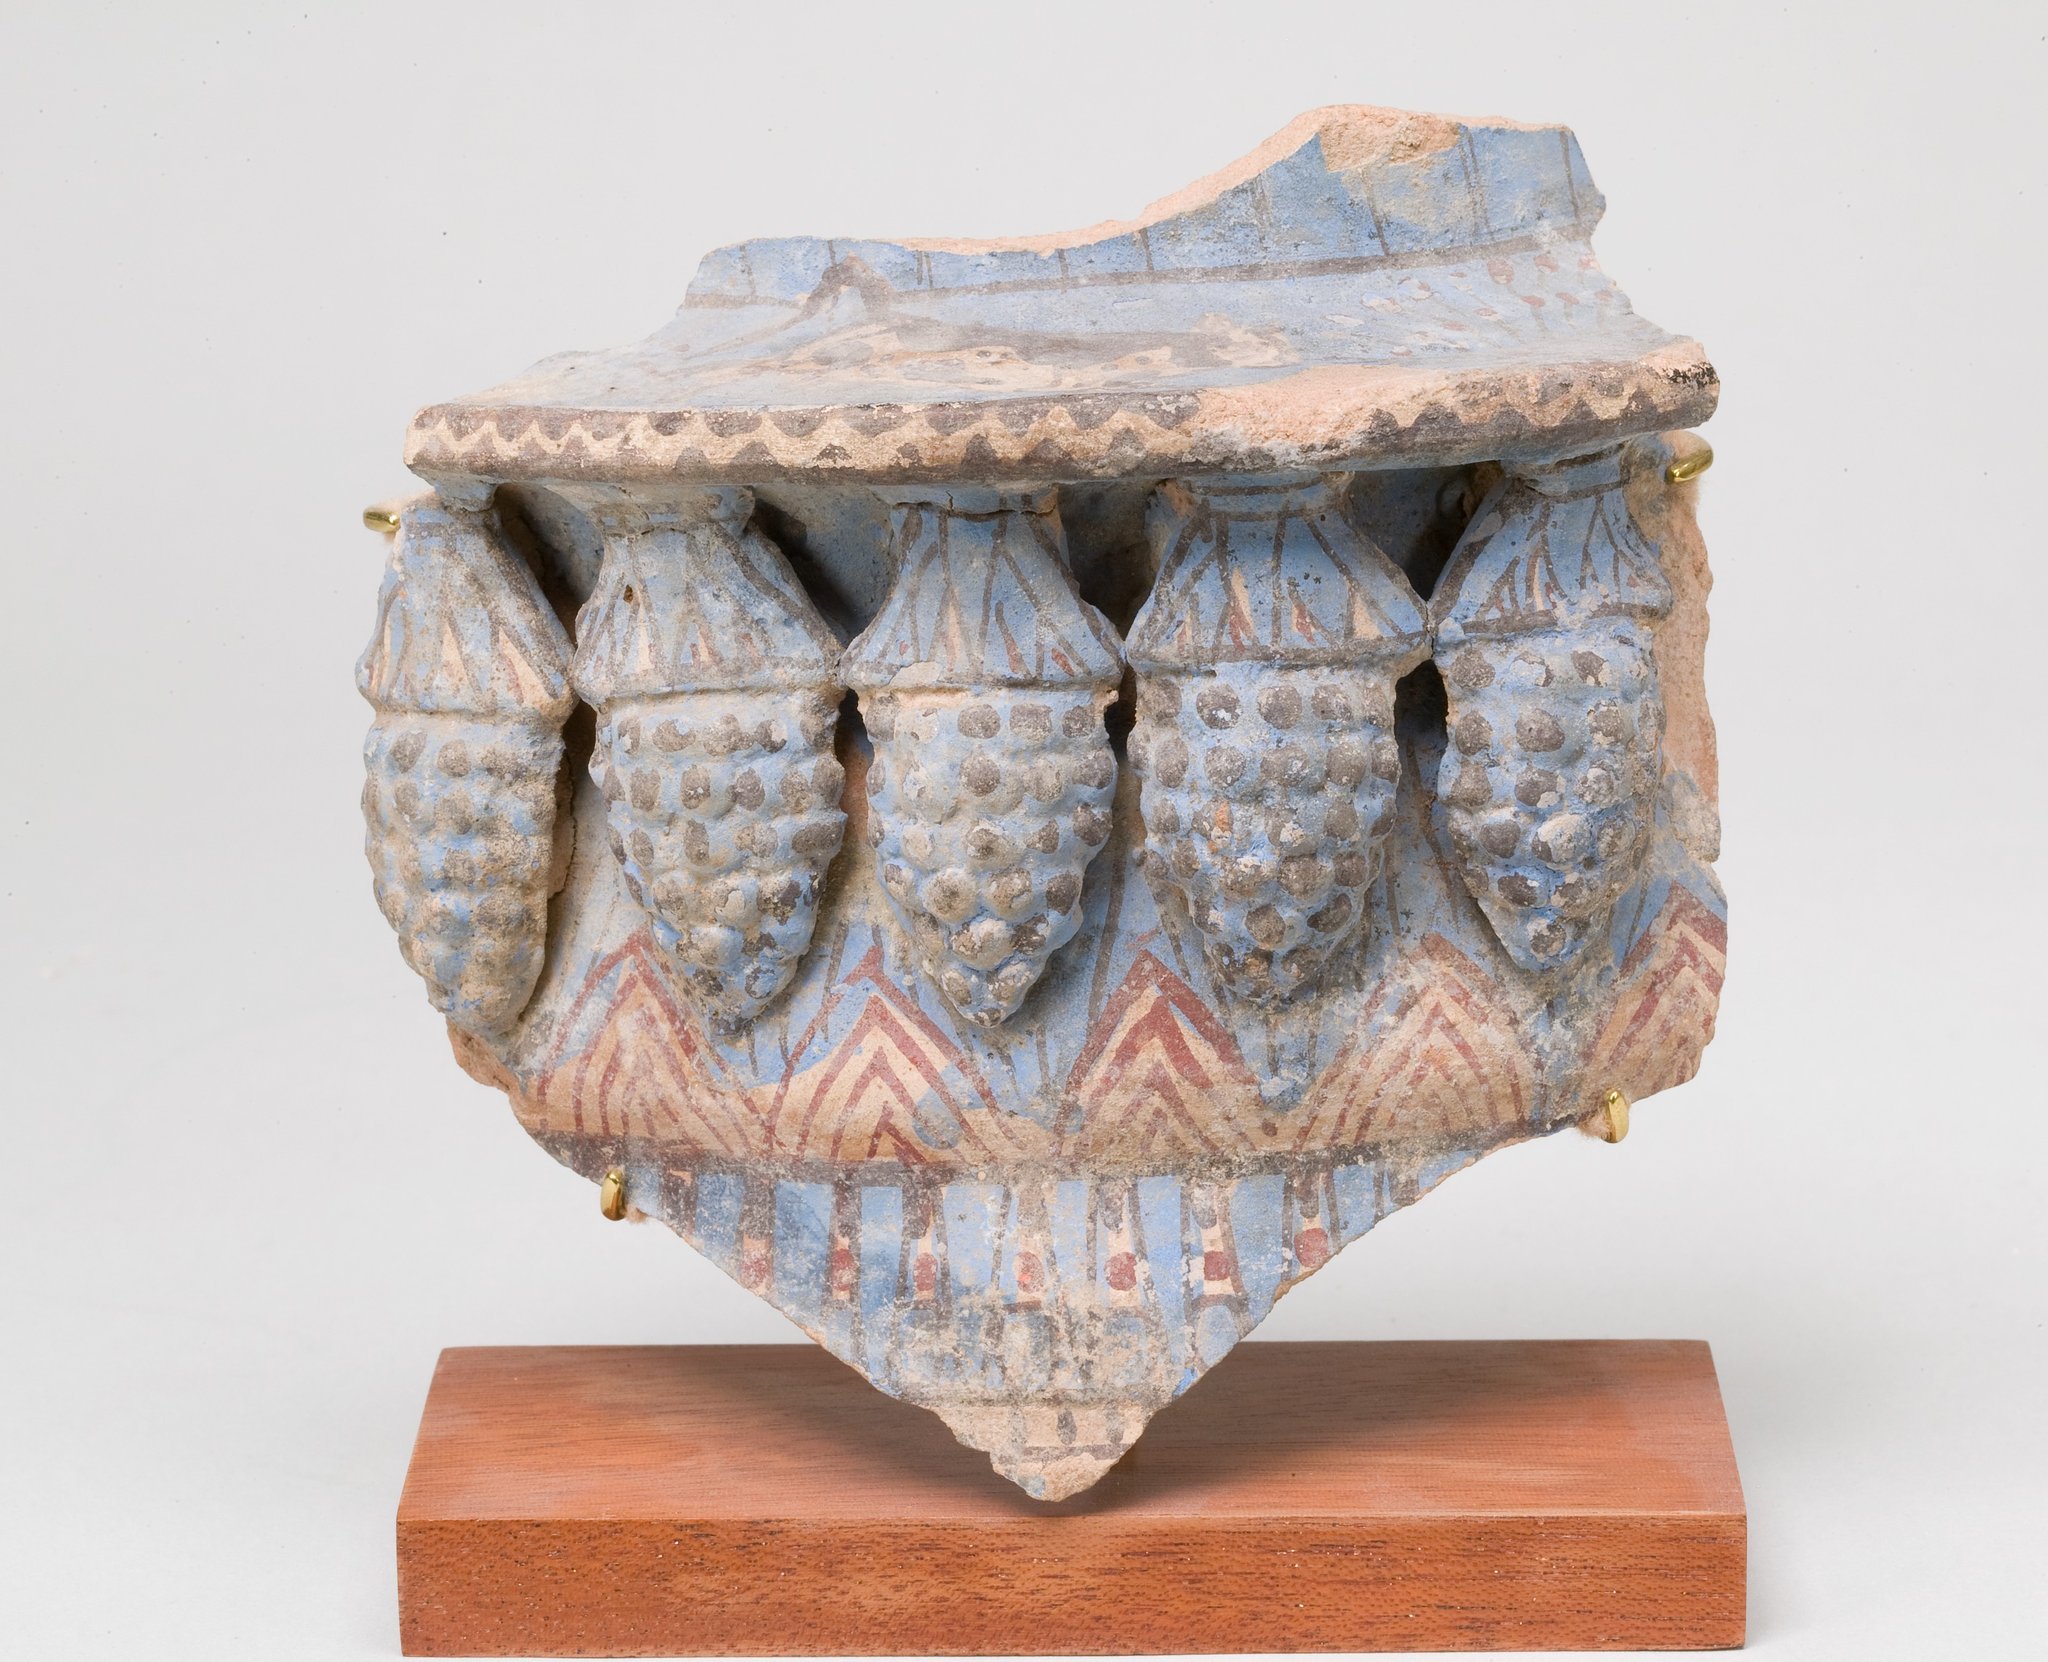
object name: jar, molded grape, blue painted ware, calf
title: Blue-Painted Jar Fragment With Molded Decoration from Malqata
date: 1390-1352 BCE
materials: paint, pottery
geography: egypt